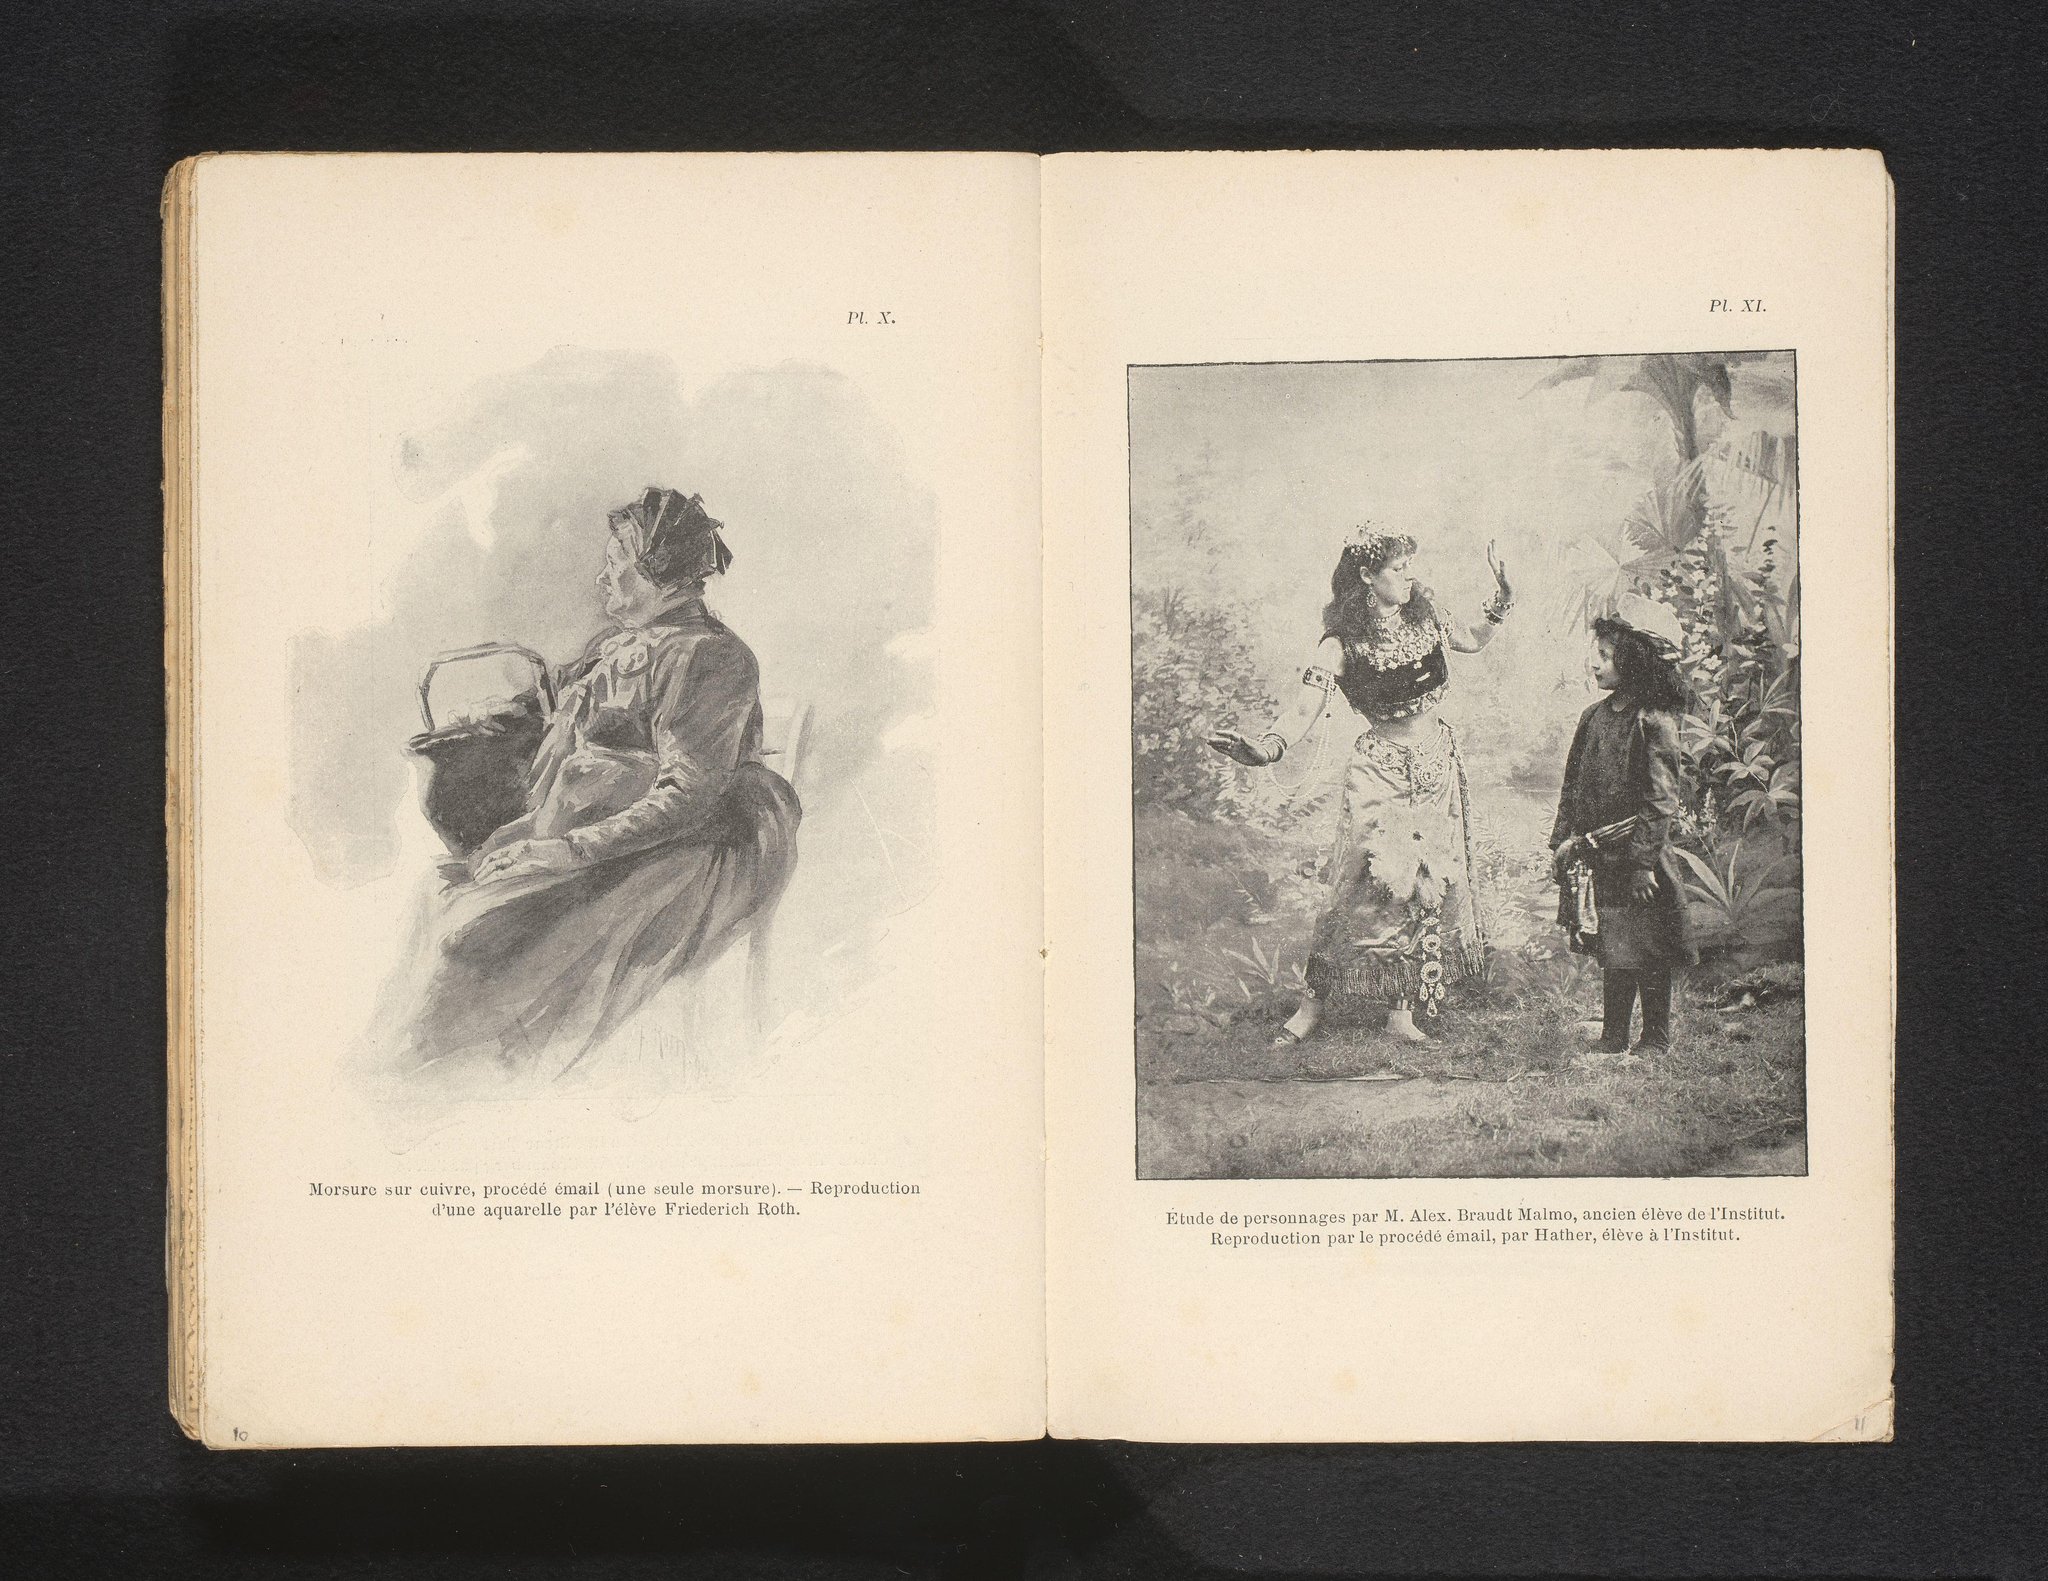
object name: page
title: Fotoreproductie van een aquarel van een oude vrouw op een stoel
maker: friederich roth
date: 1888-1898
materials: paper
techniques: autotype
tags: old woman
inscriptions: inscription: ‘Morsurc sur cuivre, procédé émail (une seule morsure).’, number: ‘Pl. X.’